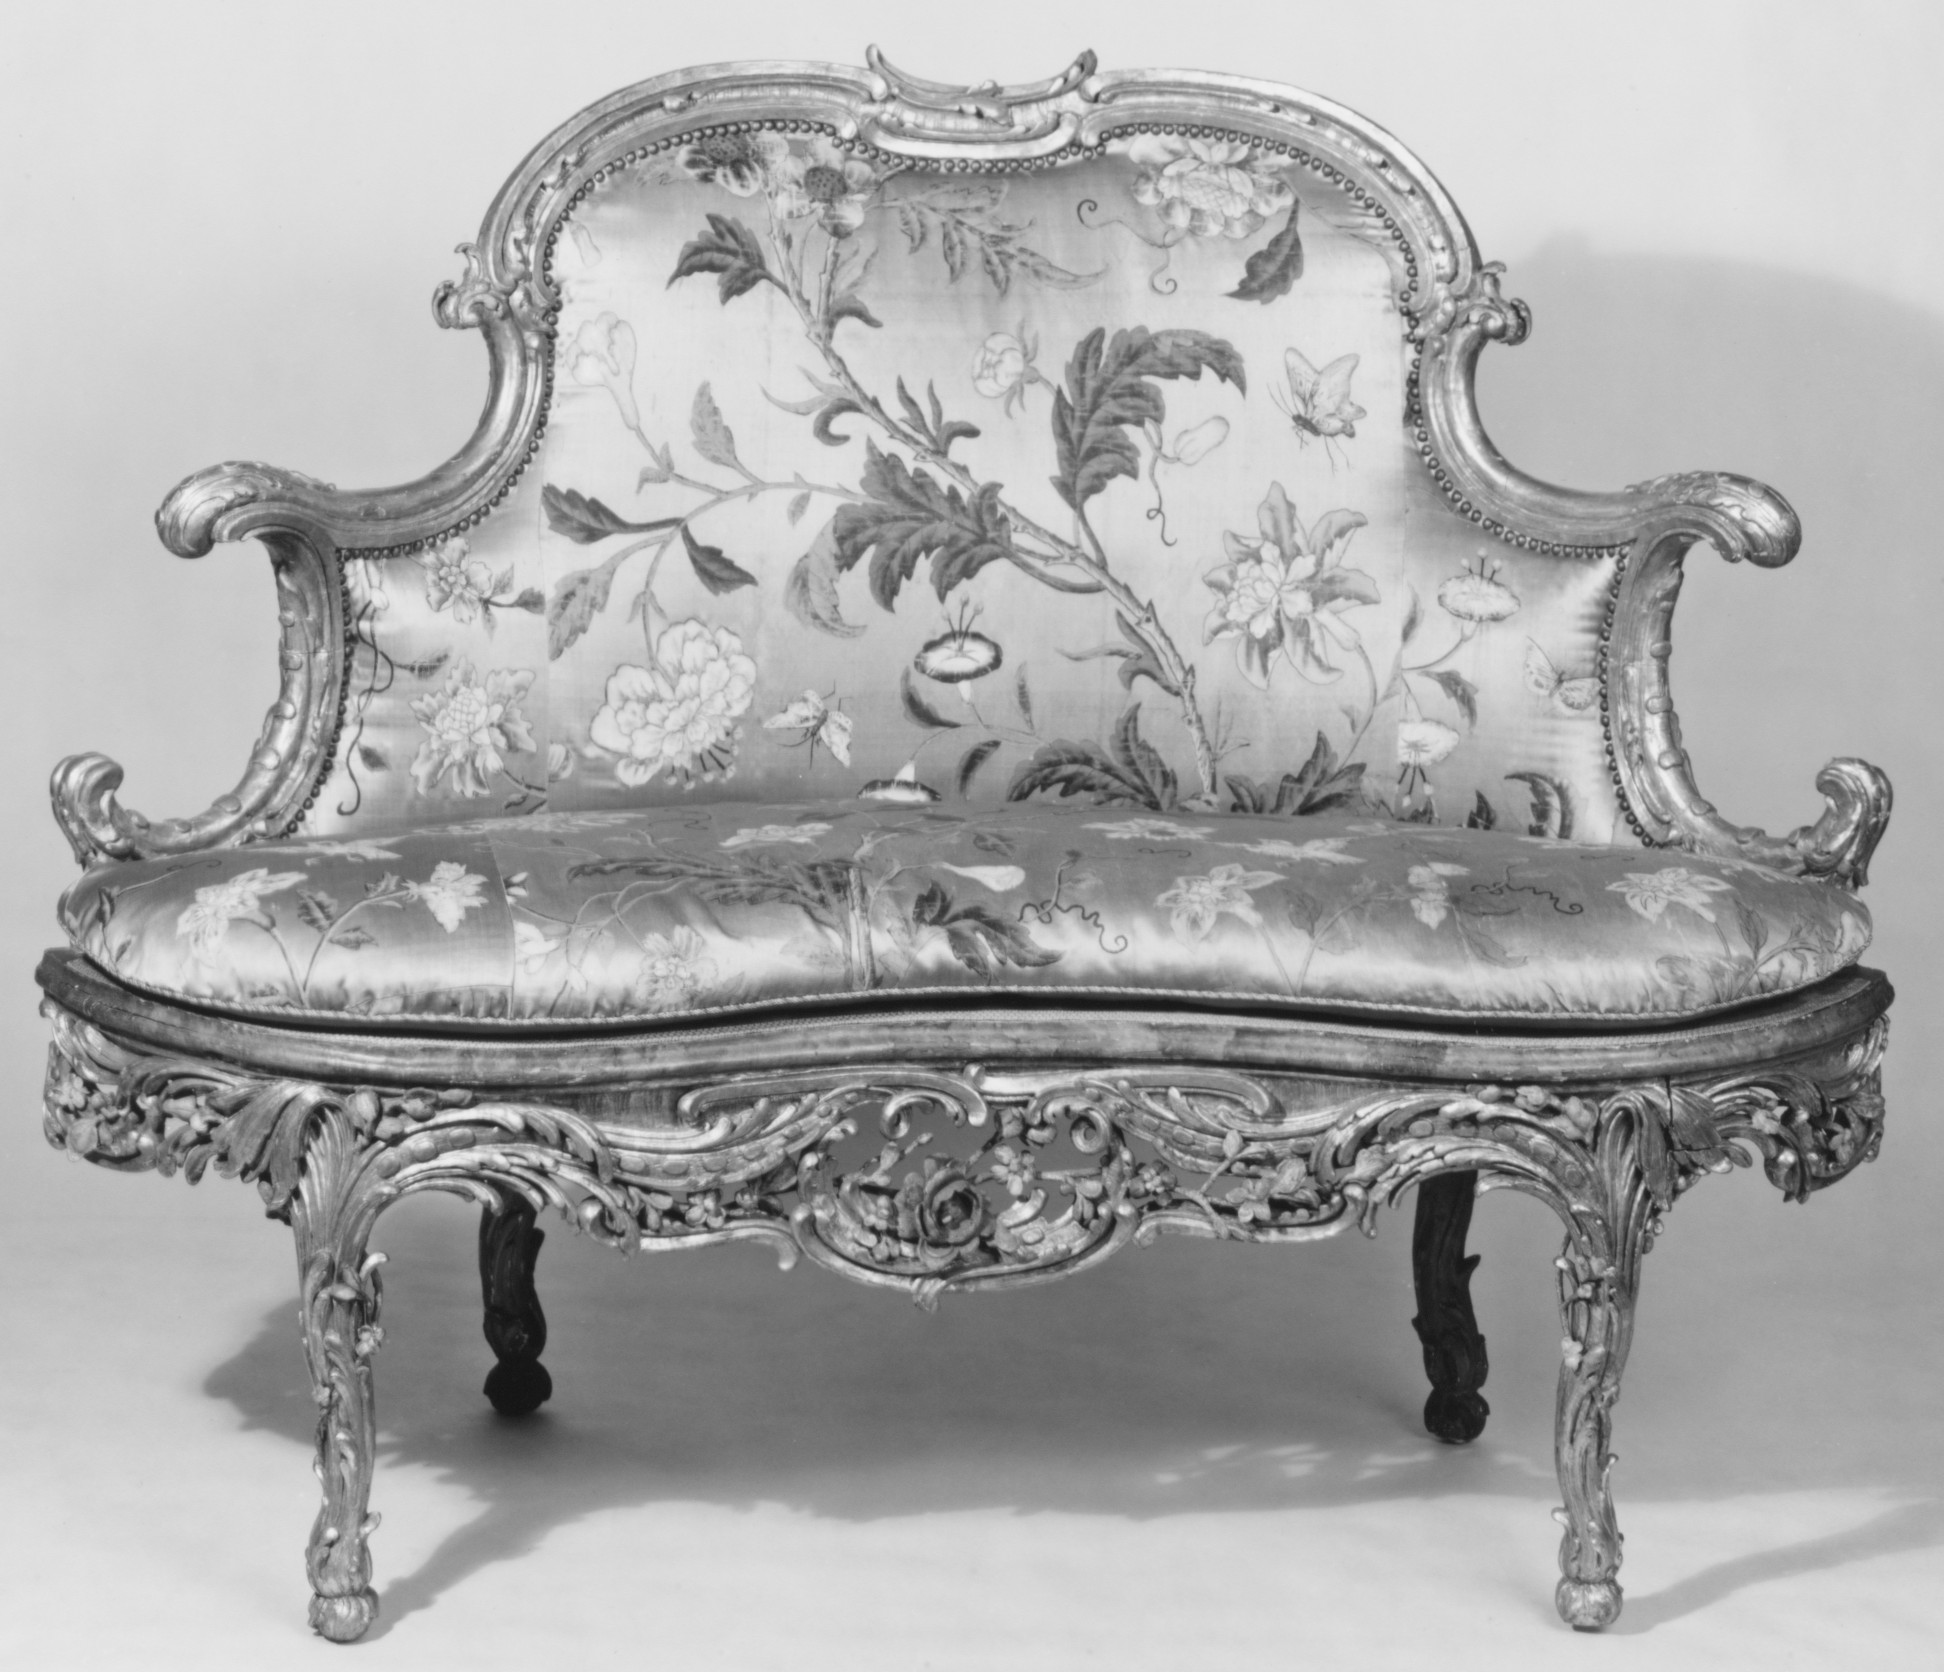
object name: upholstery panel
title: Upholstery panels for a settee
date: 1763-1764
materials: silk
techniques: painting